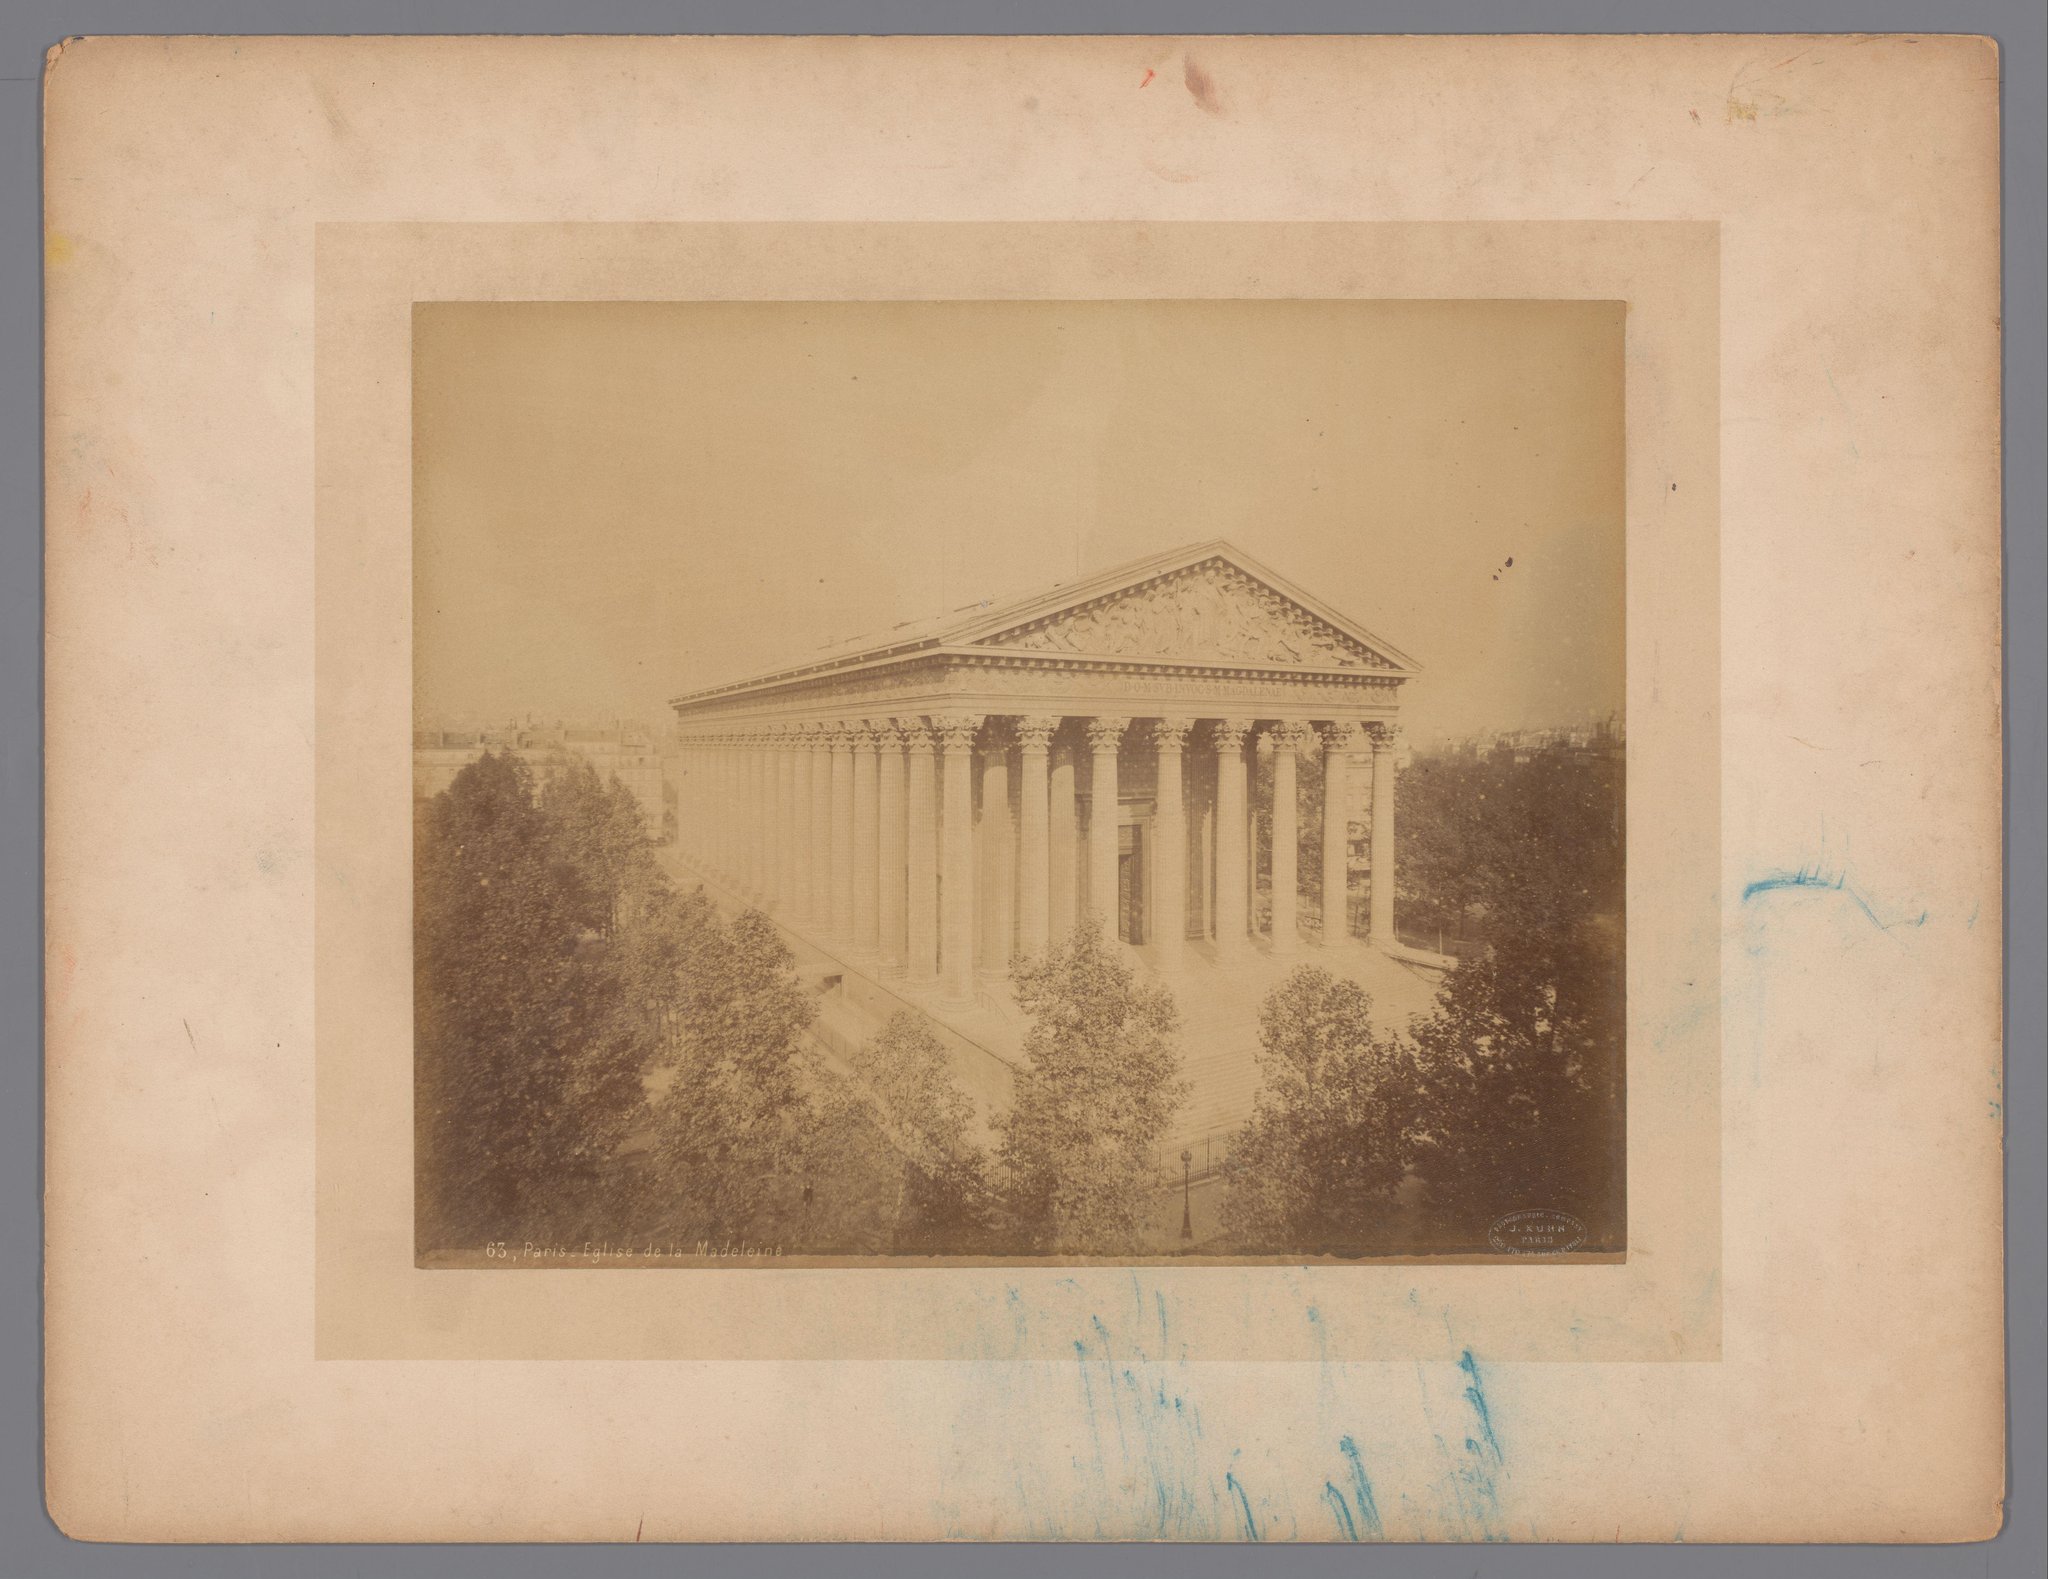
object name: photograph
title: Église de la Madeleine, Parijs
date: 1885-1910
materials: cardboard, paper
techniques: albumen print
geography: paris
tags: madeleine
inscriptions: number: ‘2.’, check stamp: ‘Photographic Company//J. Kühn//Paris//220 170174 Rue de Rivoli’, inscription: ‘63, Paris, Eglise de la Madeleine’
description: Église de la Madeleine, Parijs, Frankrijk.